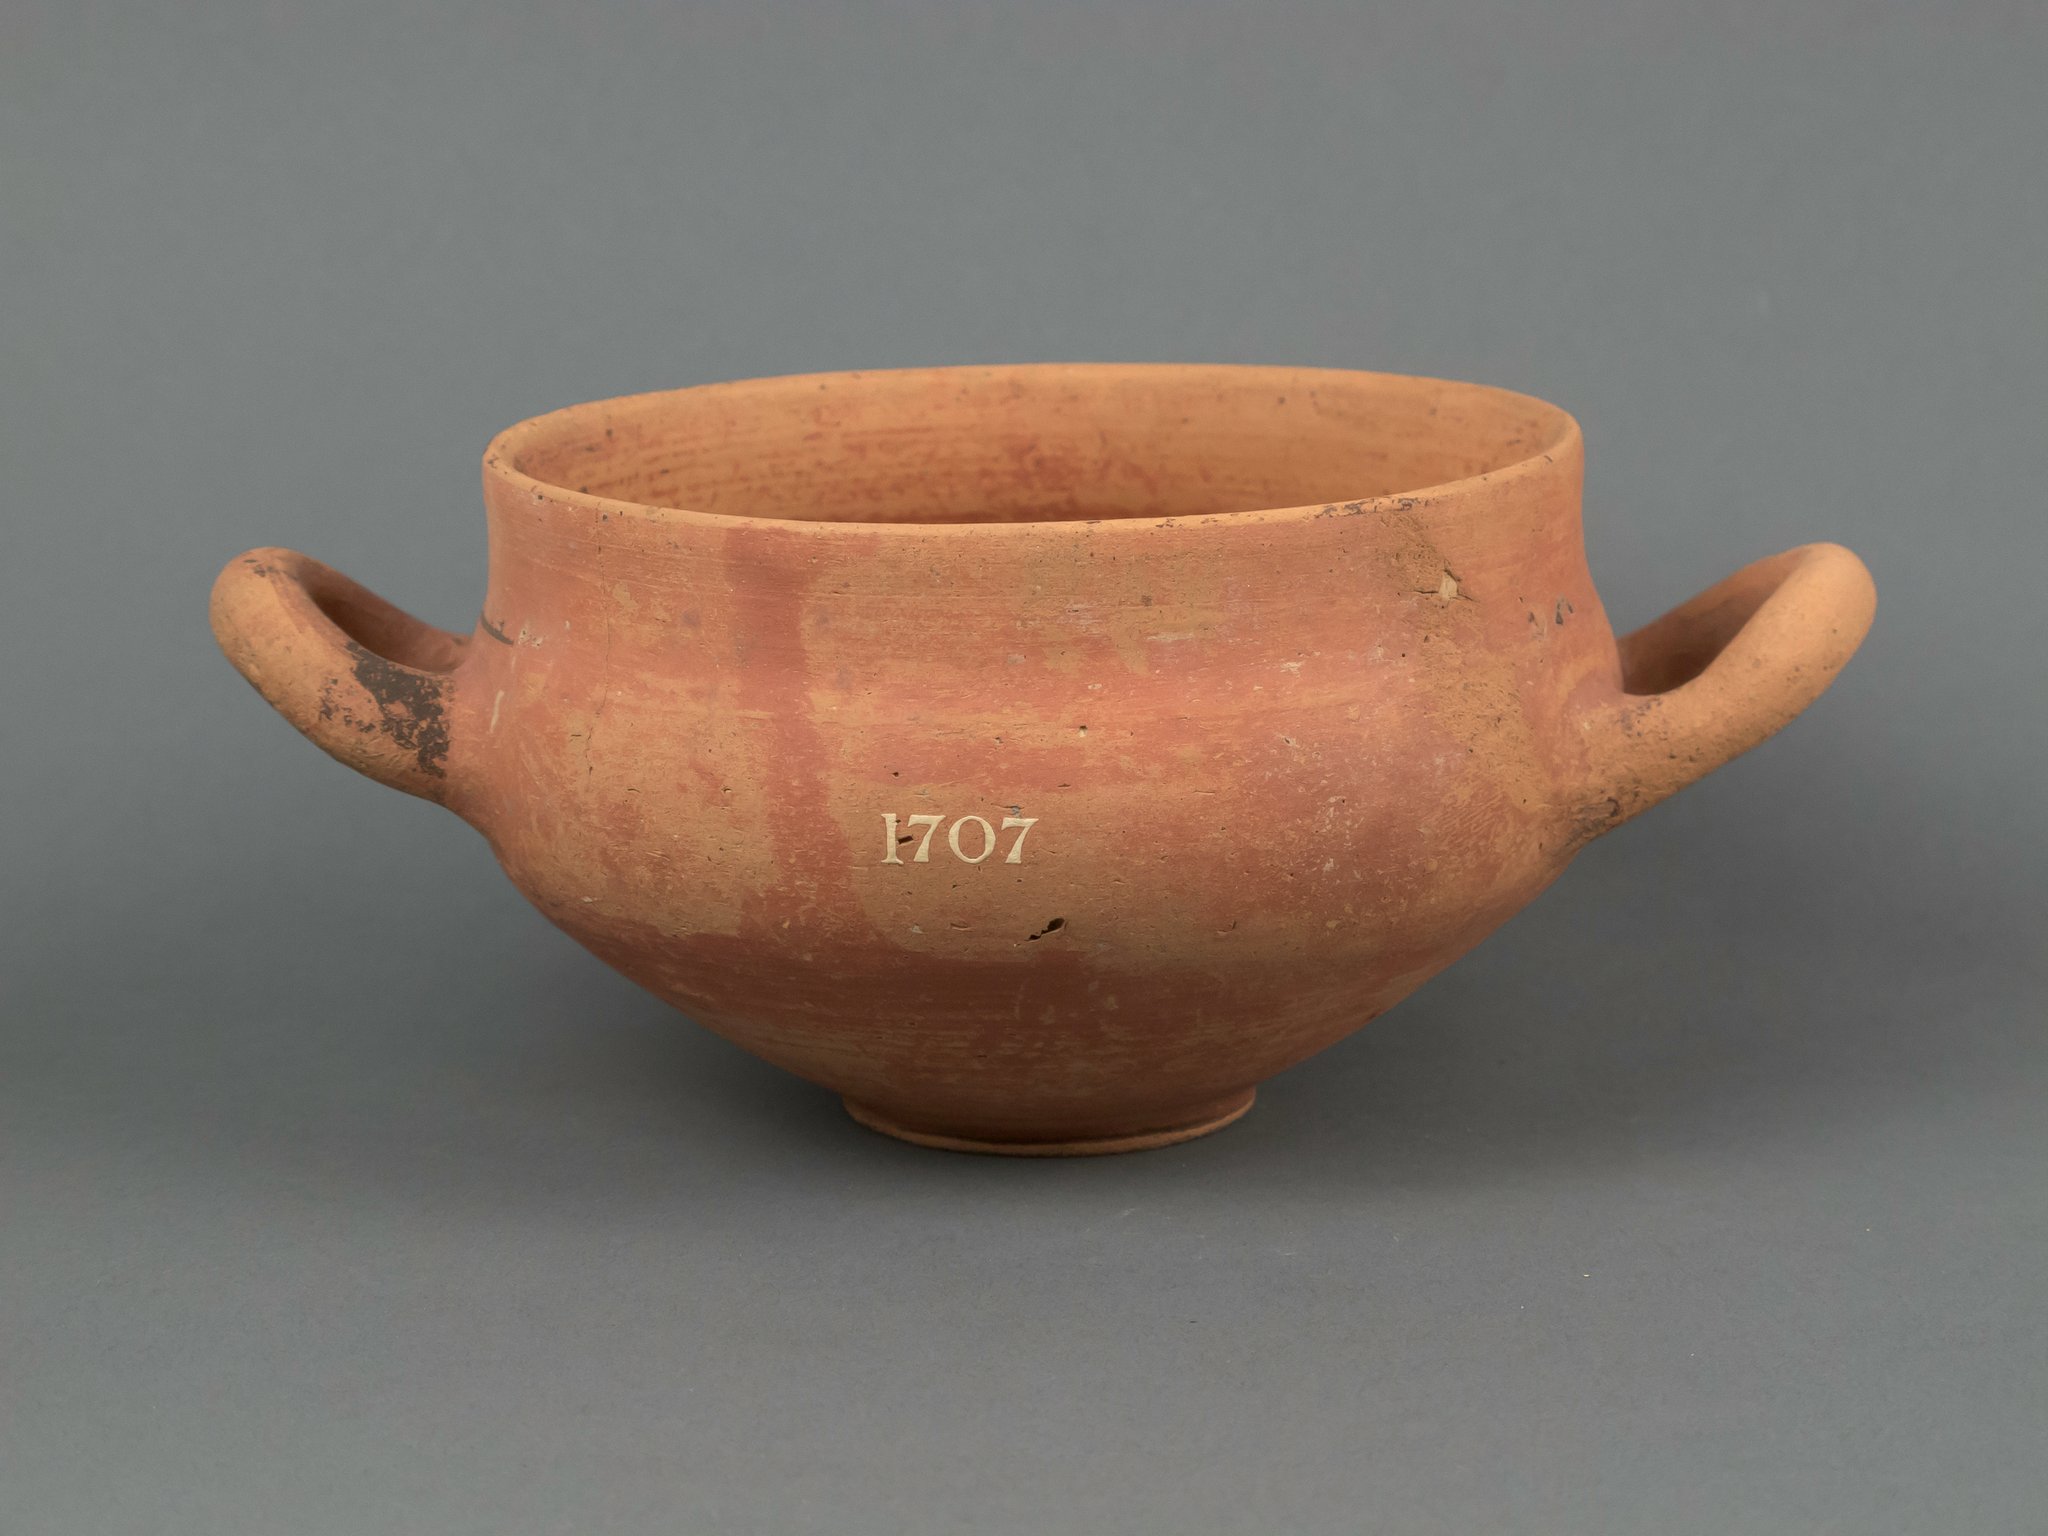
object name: skyphos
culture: cypriot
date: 750-700 BCE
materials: terracotta